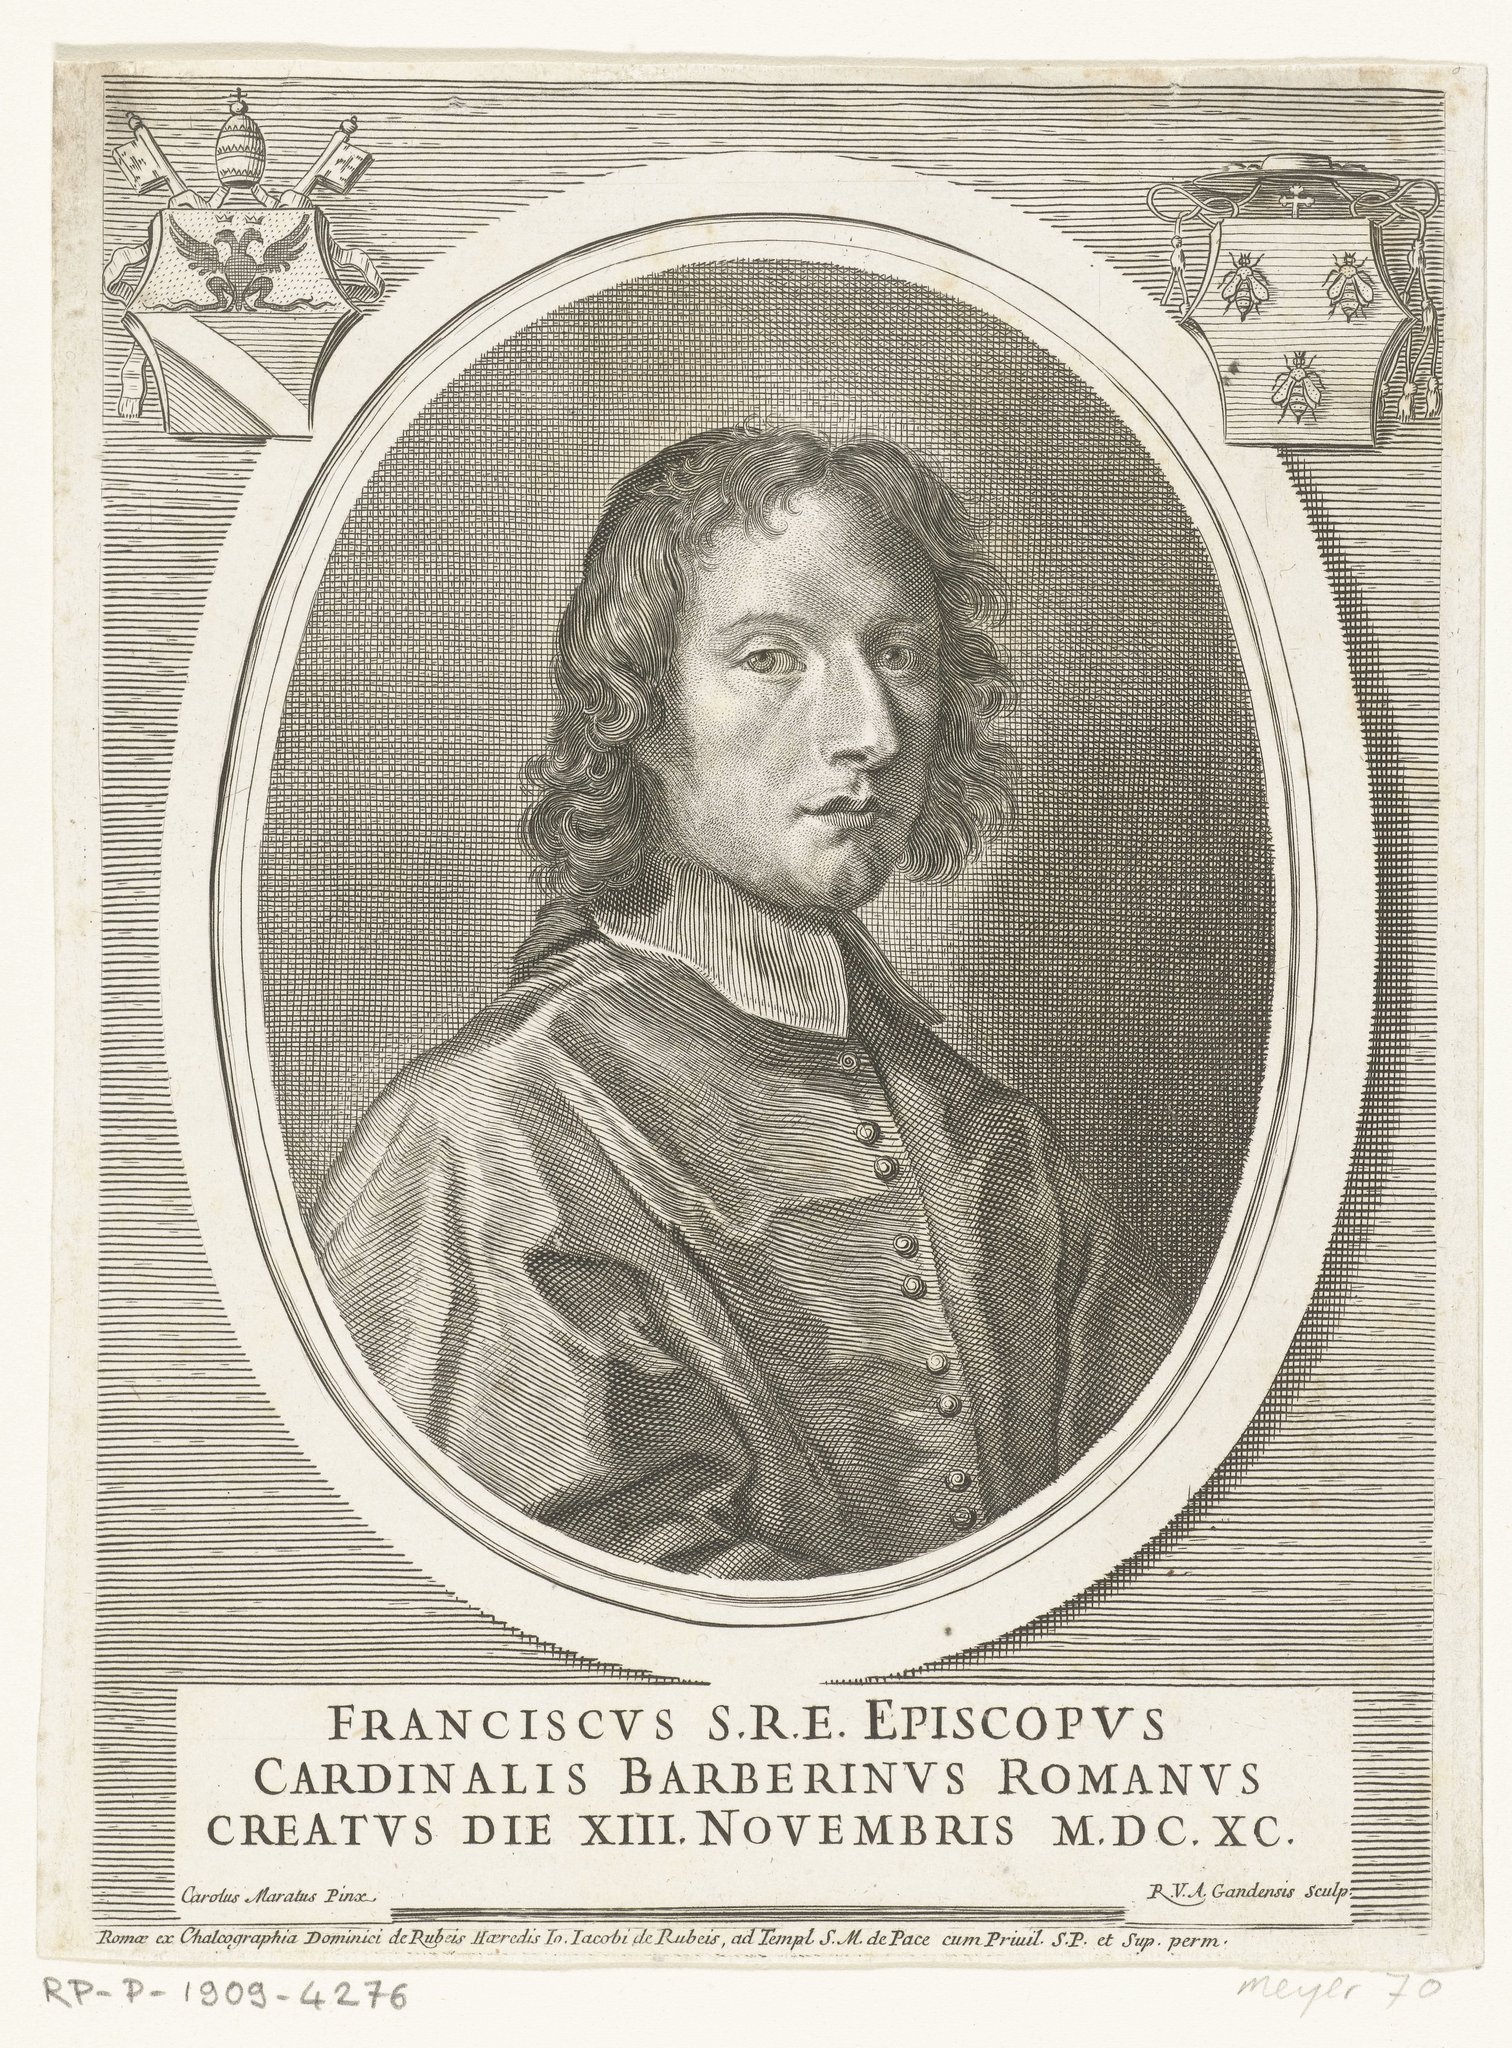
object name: print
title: Portret van kardinaal Francesco Barberini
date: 1690-1723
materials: paper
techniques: engraving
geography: rome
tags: rome, francesco barberini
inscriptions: collector's mark: Lugt 2228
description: Borstbeeld van kardinaal Francesco Barberini op 38 jarige leeftijd, gemaakt ter gelegenheid van zijn inwijding als kardinaal. In de bovenhoeken links het pauselijk wapen van Alexander VIII, en rechts zijn eigen kardinaalswapen. Onder het portret zijn naam en titels.